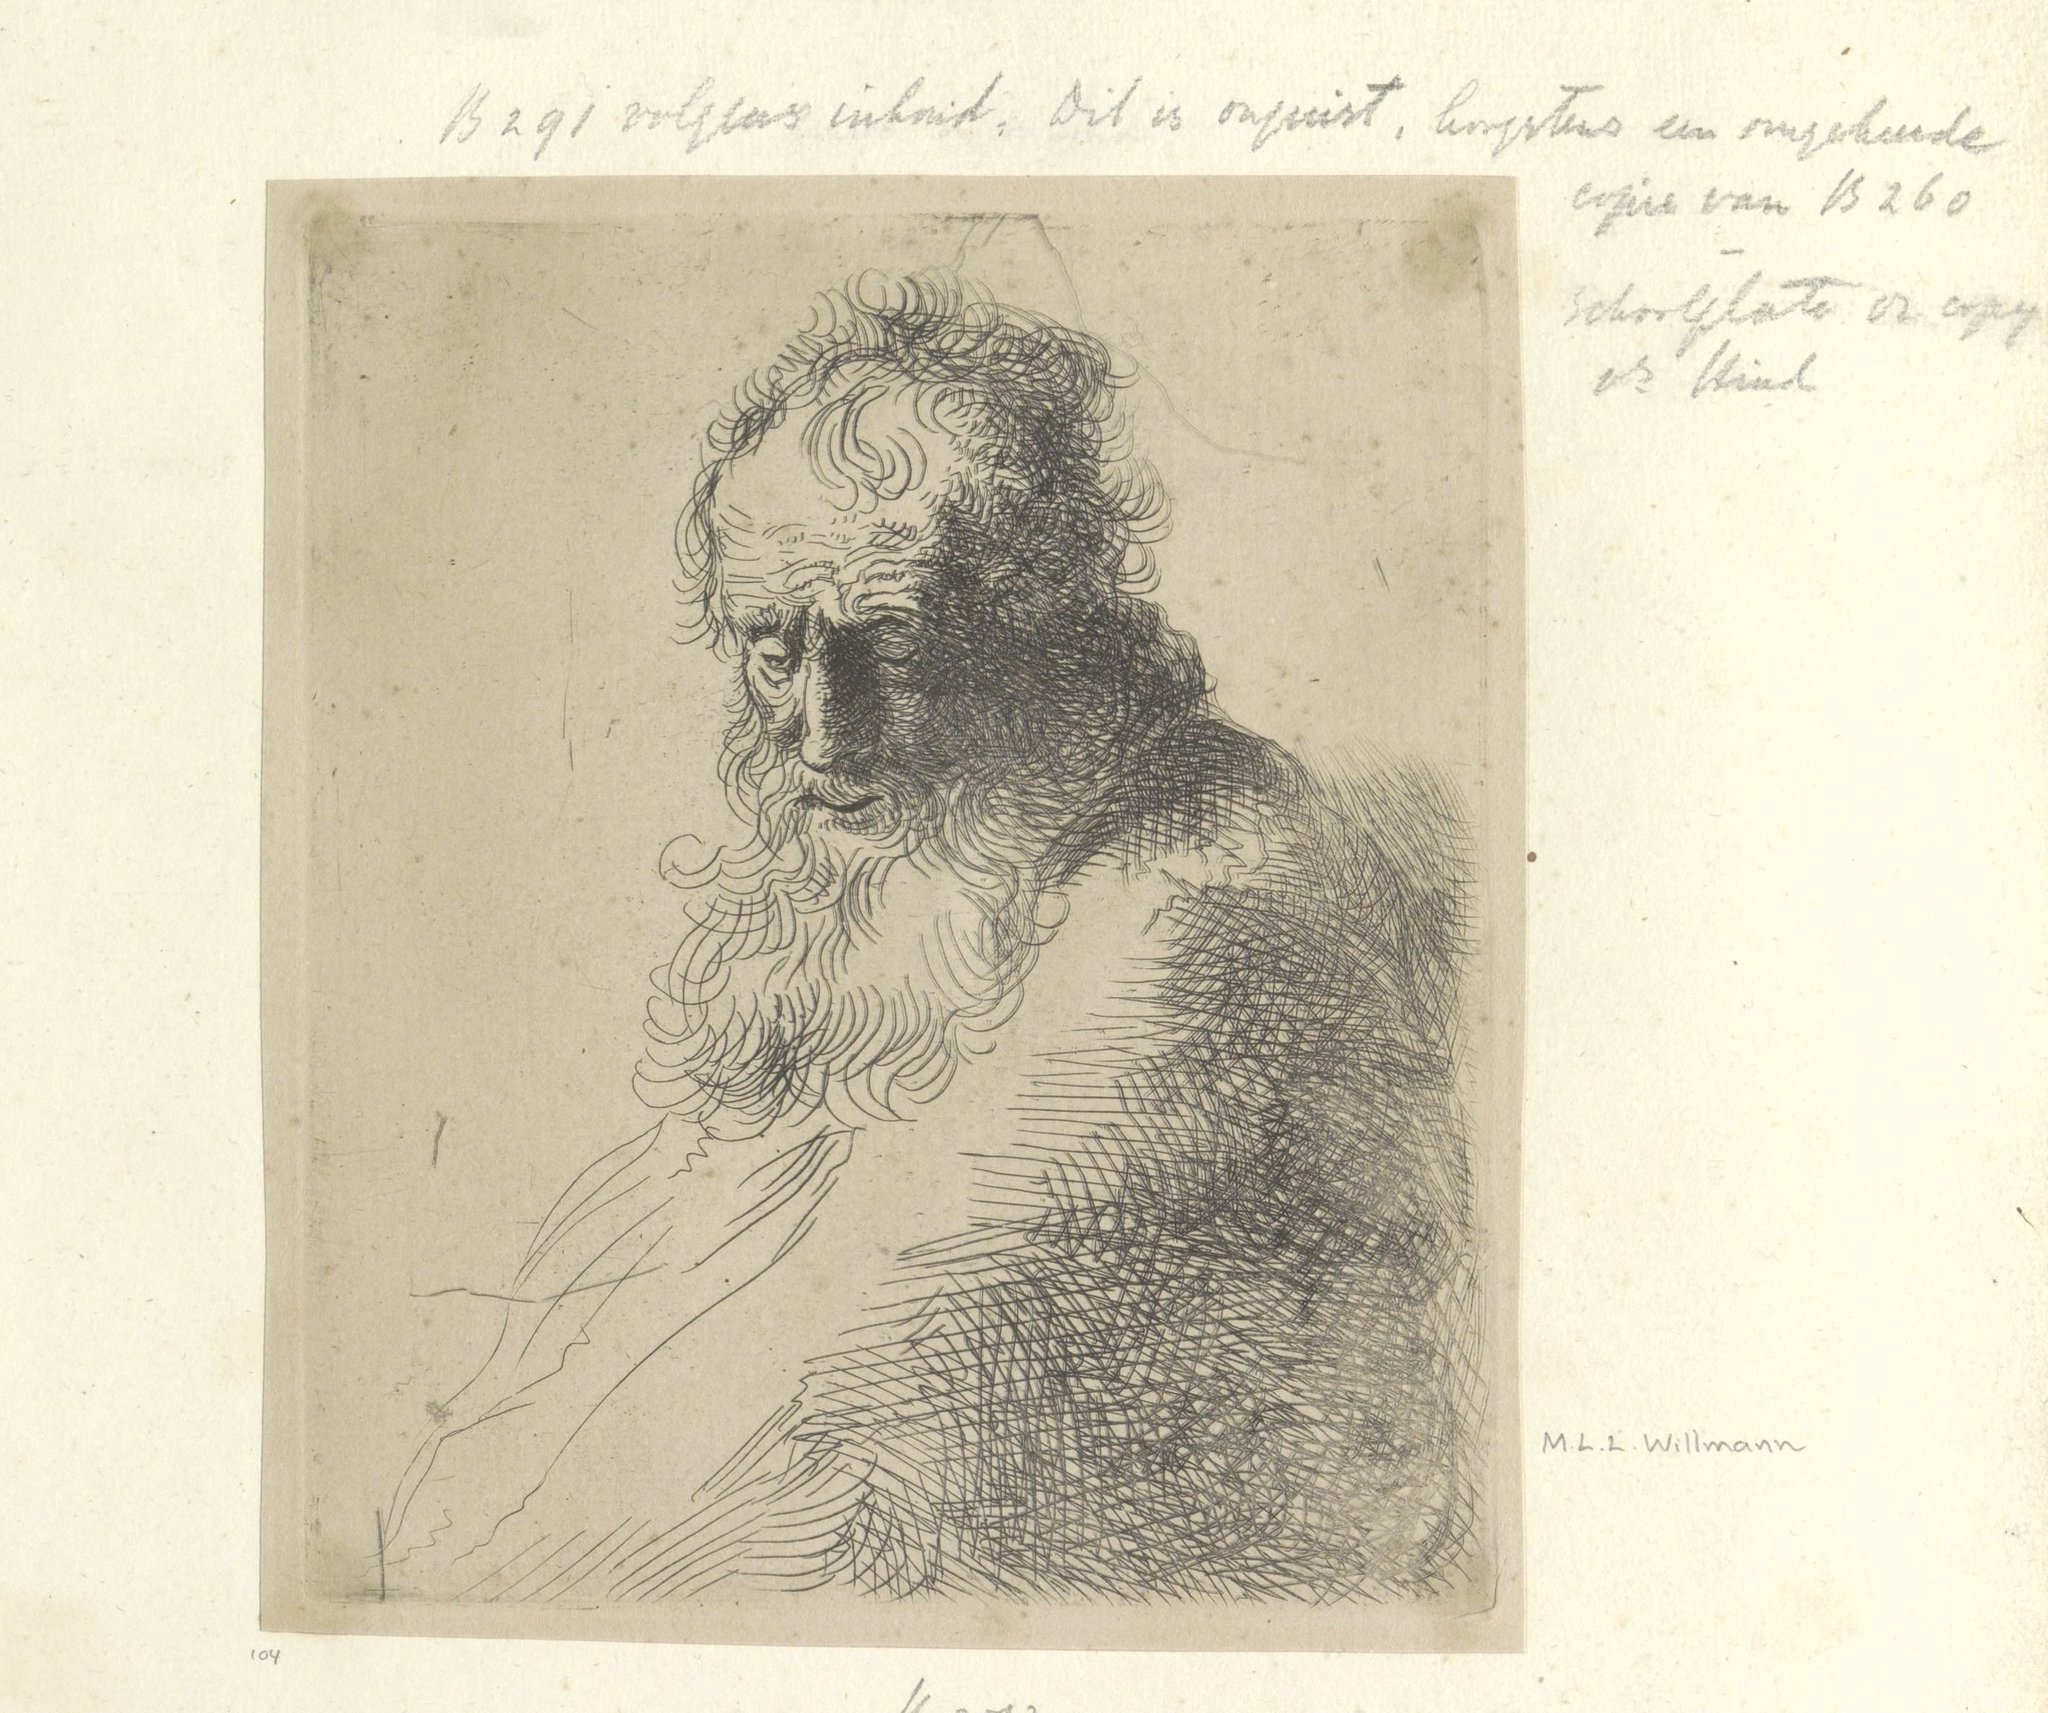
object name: album leaf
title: Buste van een oude man met baard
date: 1640-1706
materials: paper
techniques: etching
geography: paris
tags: old man